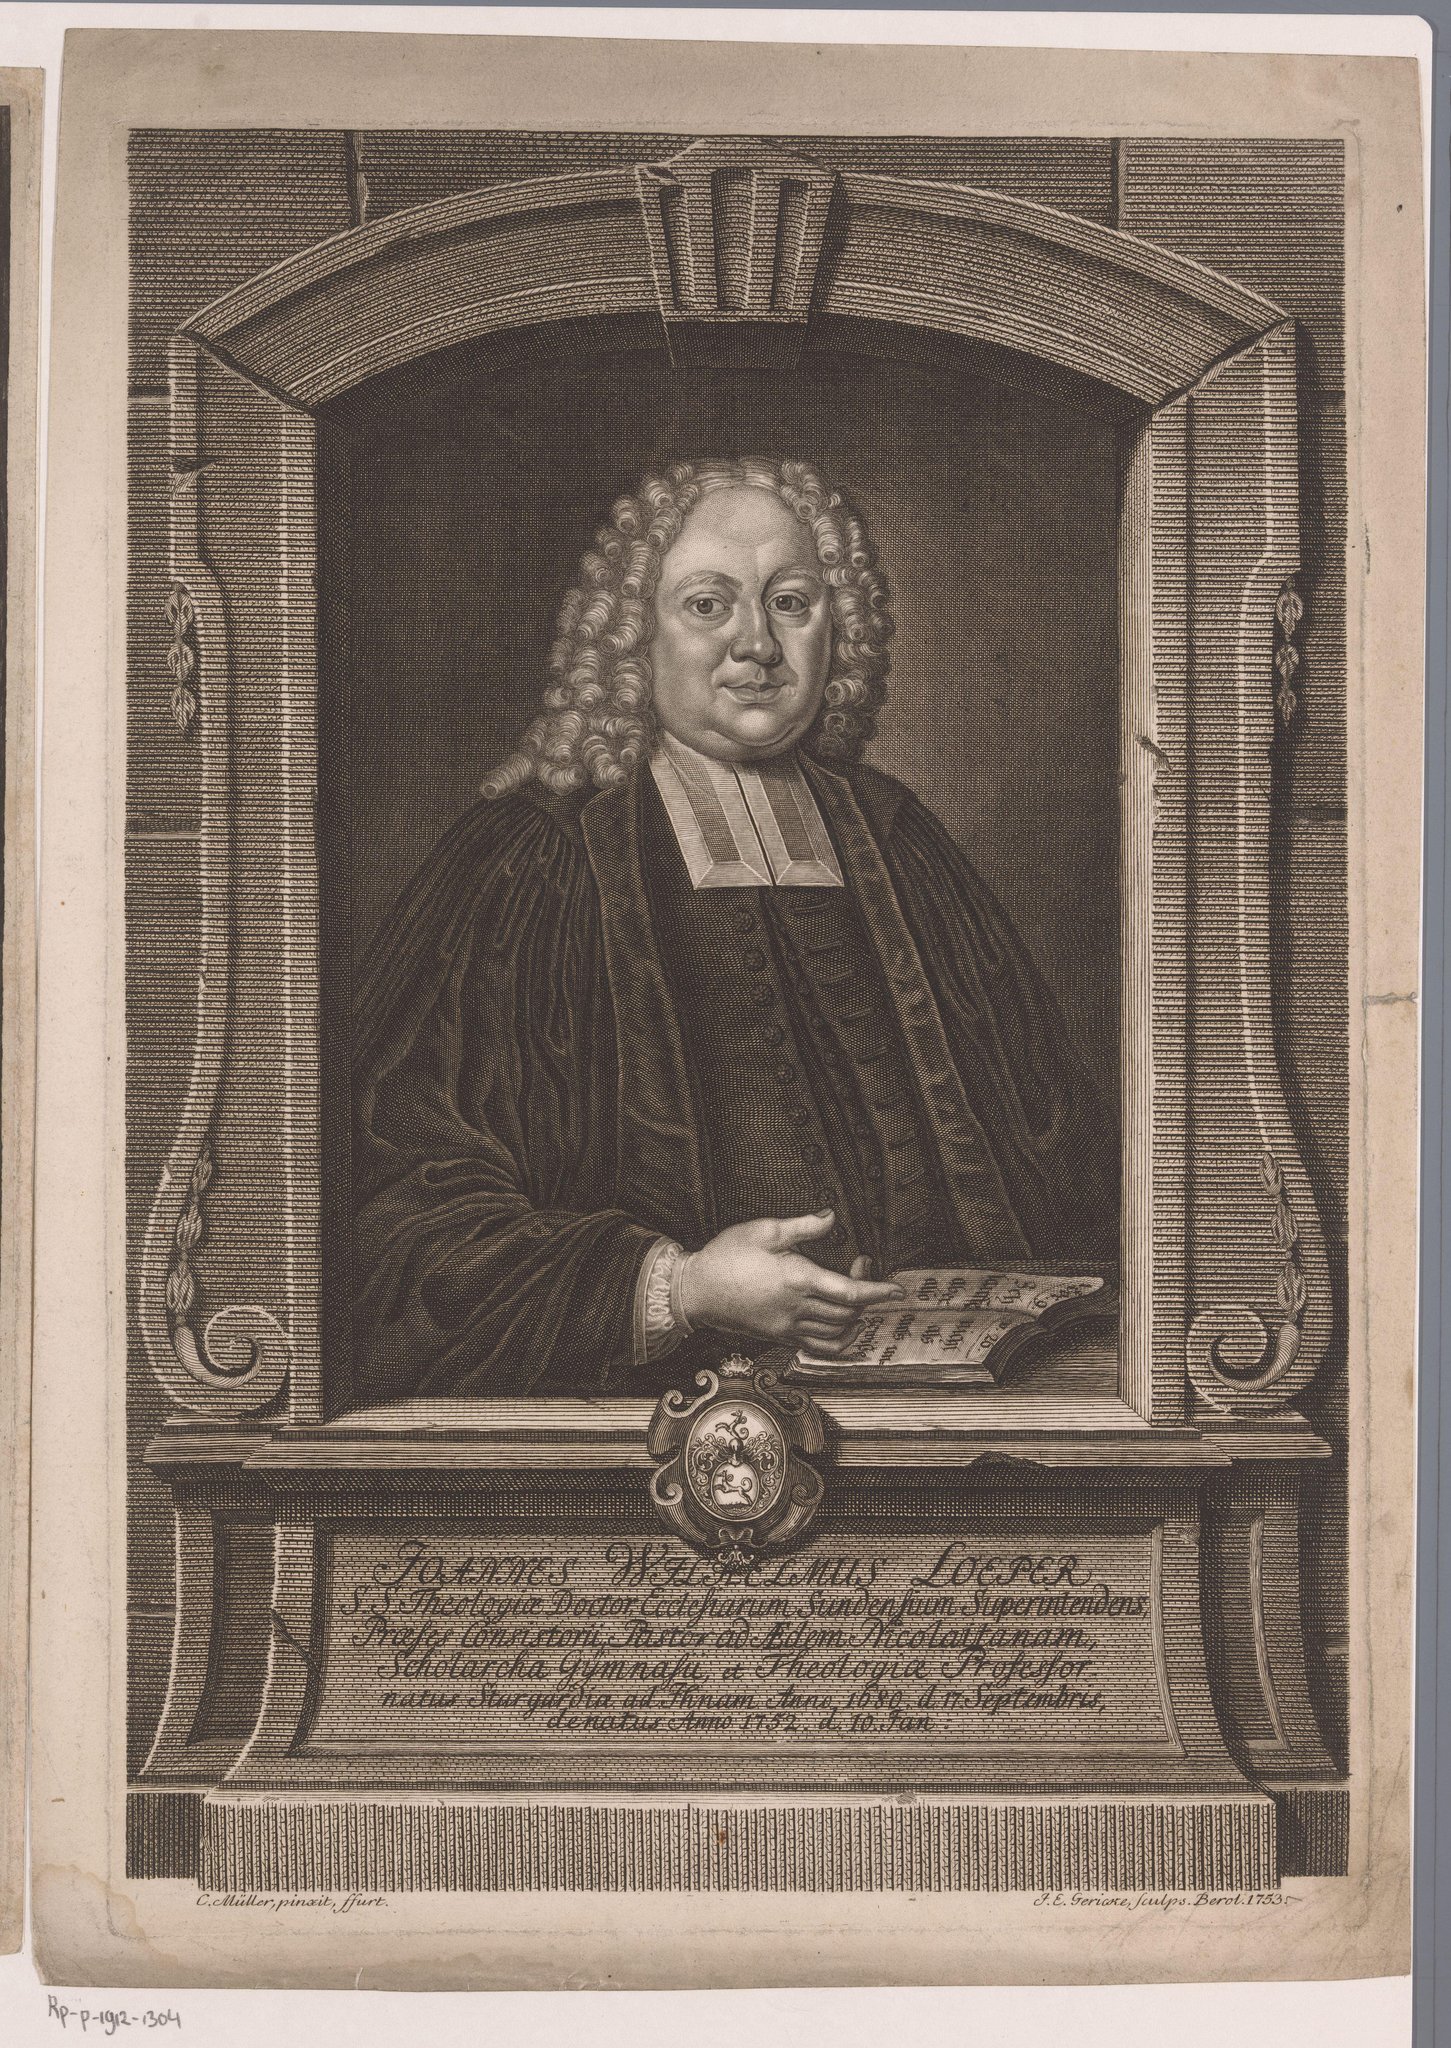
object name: print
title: Portret van Johann Wilhelm Löper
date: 1753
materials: paper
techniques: engraving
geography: berlin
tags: theologian, historical persons, book, ornament derived from architectural details, armorial bearing, heraldry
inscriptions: collector's mark: Lugt 2228